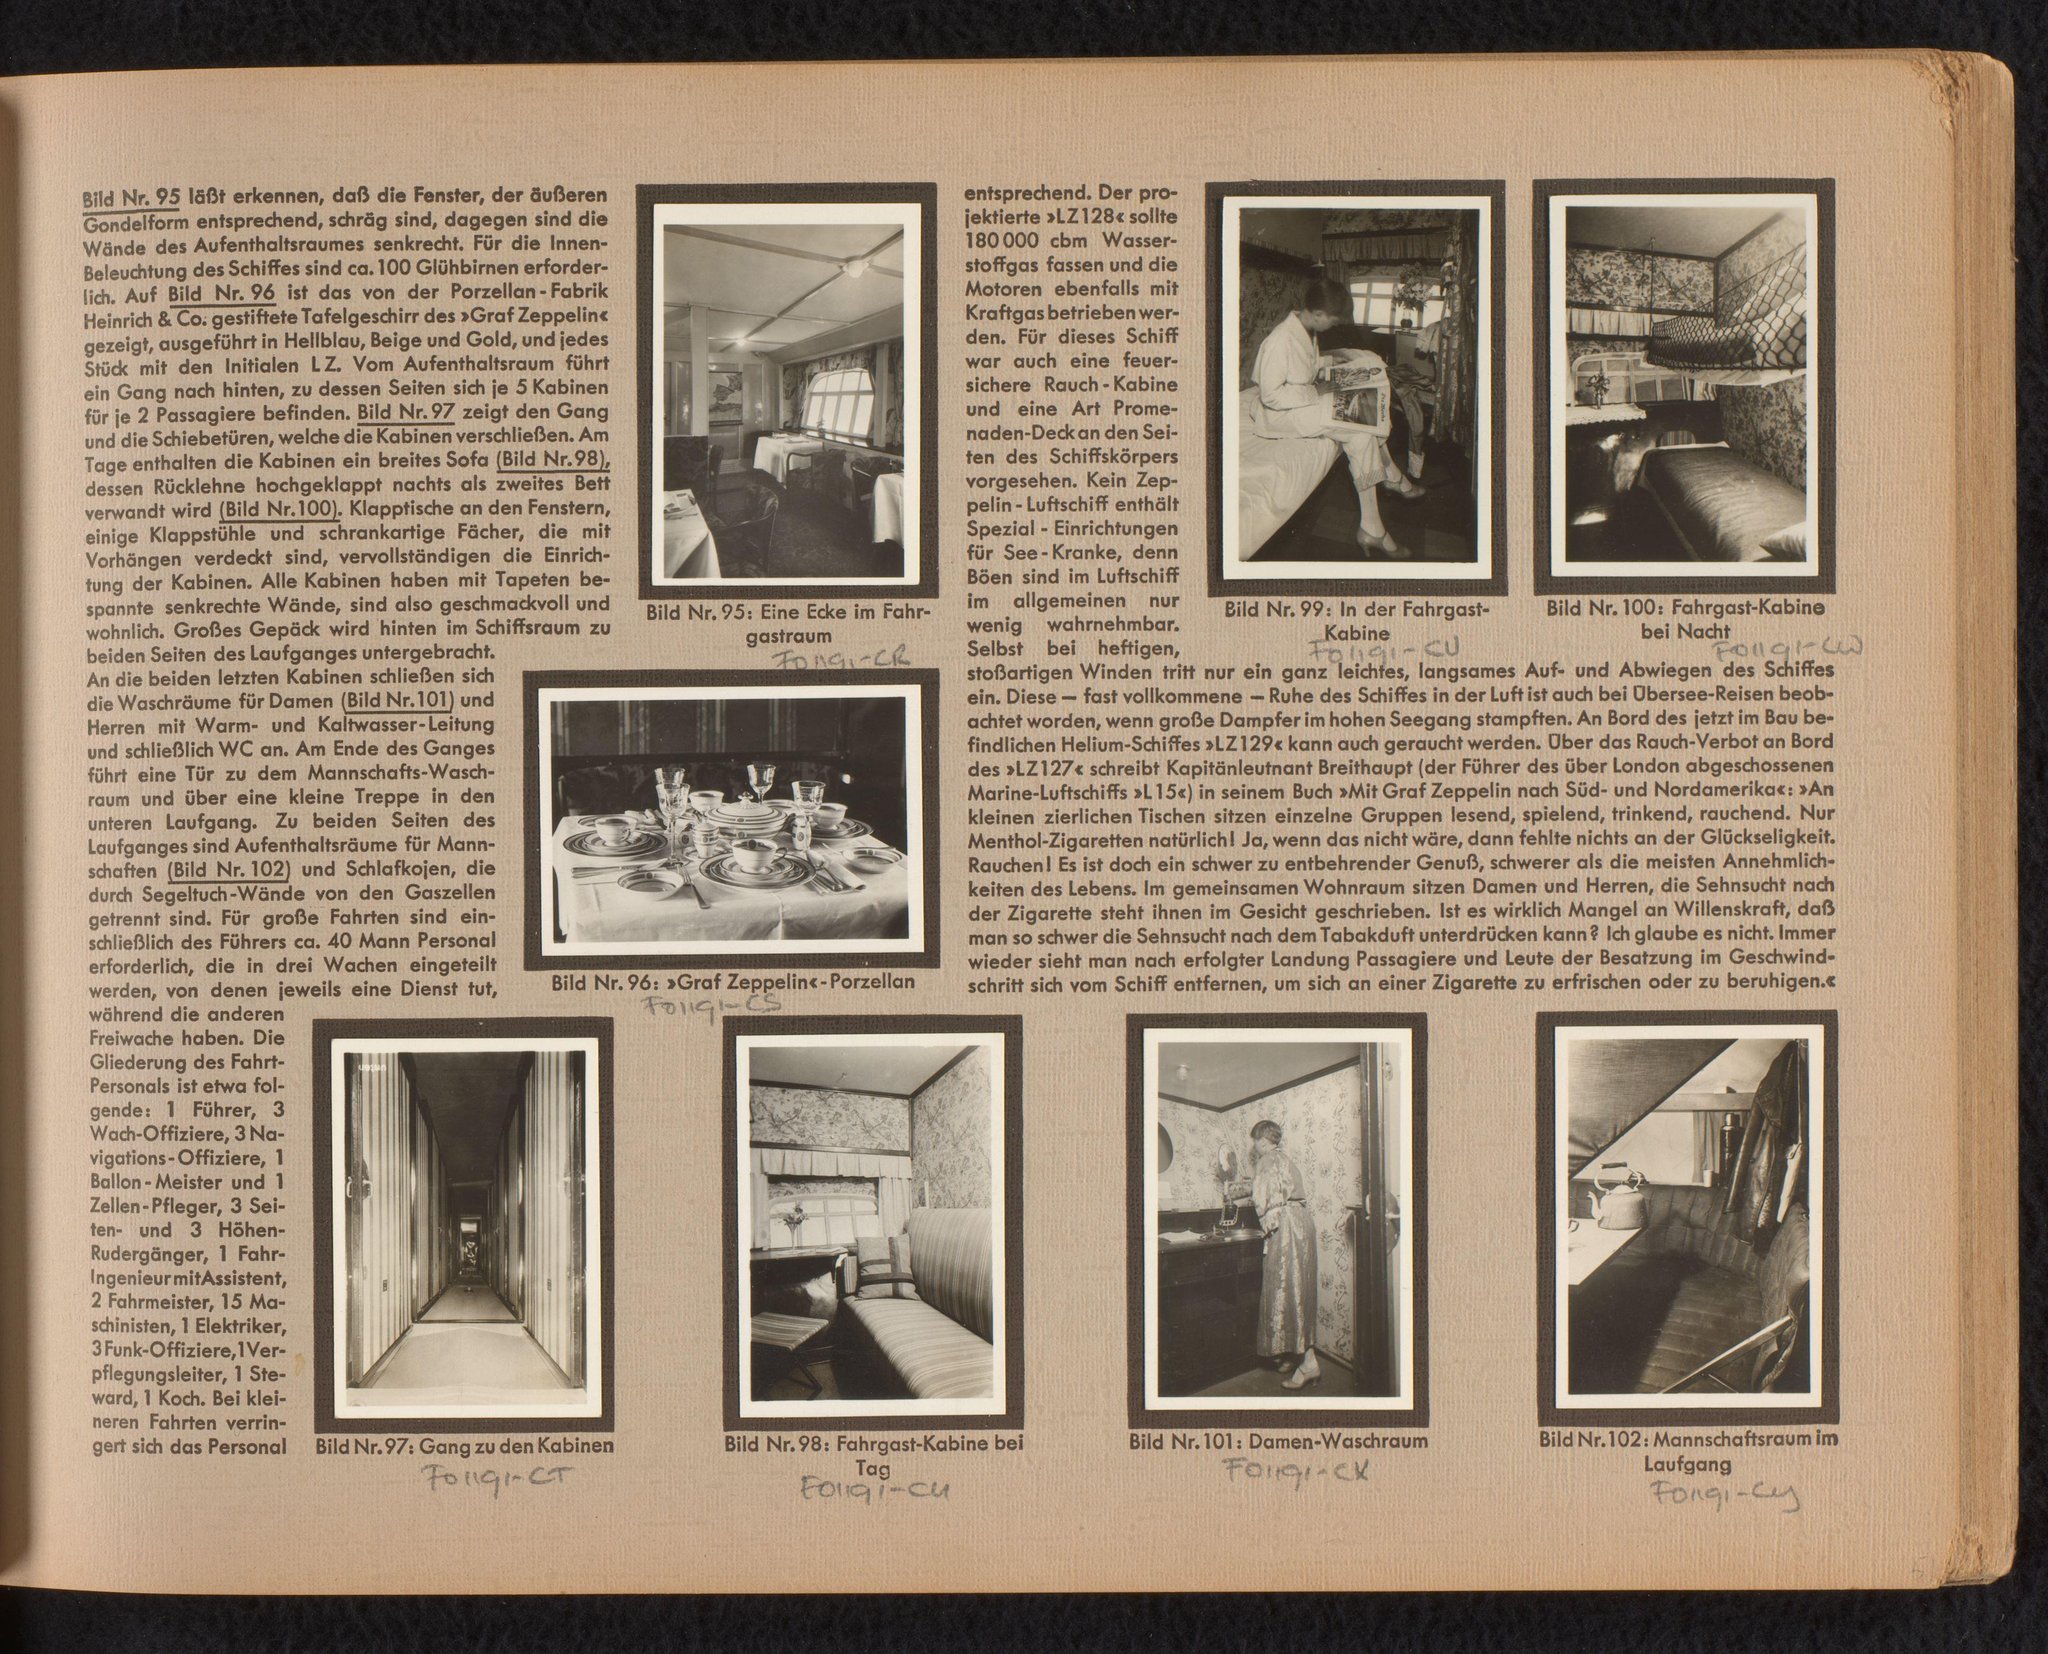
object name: photograph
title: Vertrekken in LZ127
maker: Anonymous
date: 1928-1938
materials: paper, photographic support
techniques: gelatin silver print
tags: airship, zeppelin (+ view ~ vehicle, ship, etc.), bed, dinner-service, germany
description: Acht foto's van verschillende gastenvertrekken in zeppelin LZ127. Alle foto's zijn voorzien van een nummer en titel. Deze pagina maakt deel uit van een album.